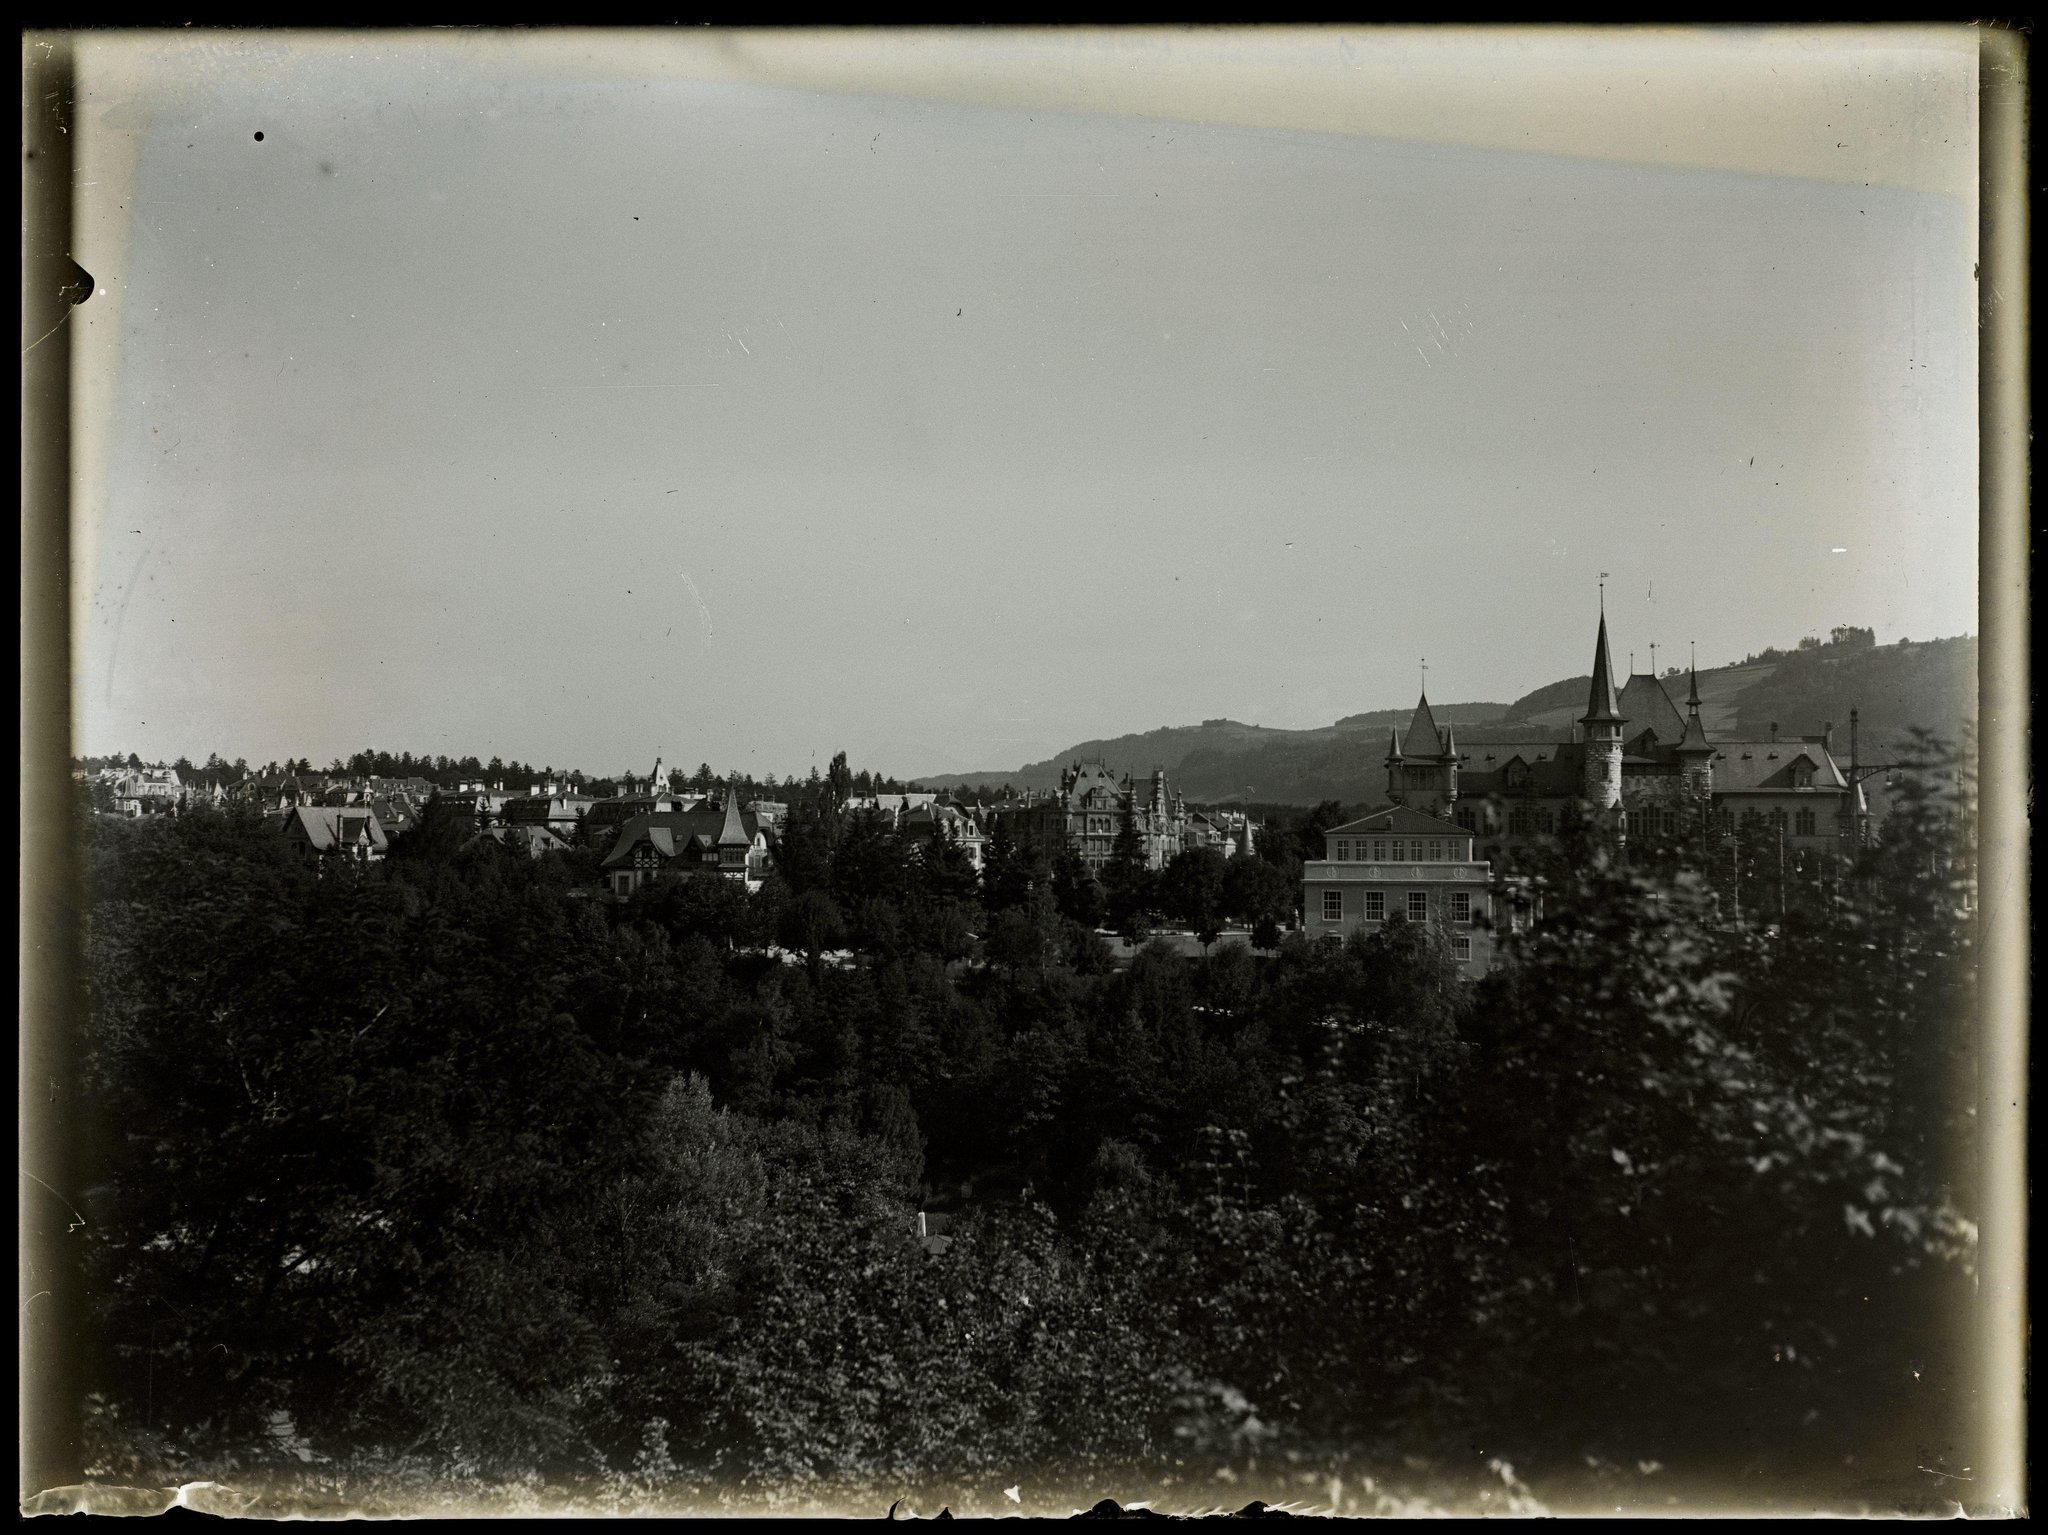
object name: glasnegatief, glasplaatnegatief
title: Gezicht op Bern, rechts het Bernisches Historisches Museum, Zwitserland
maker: Anonymous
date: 1907-1935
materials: glass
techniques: gelatin glass negative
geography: bern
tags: city-view in general; 'veduta'